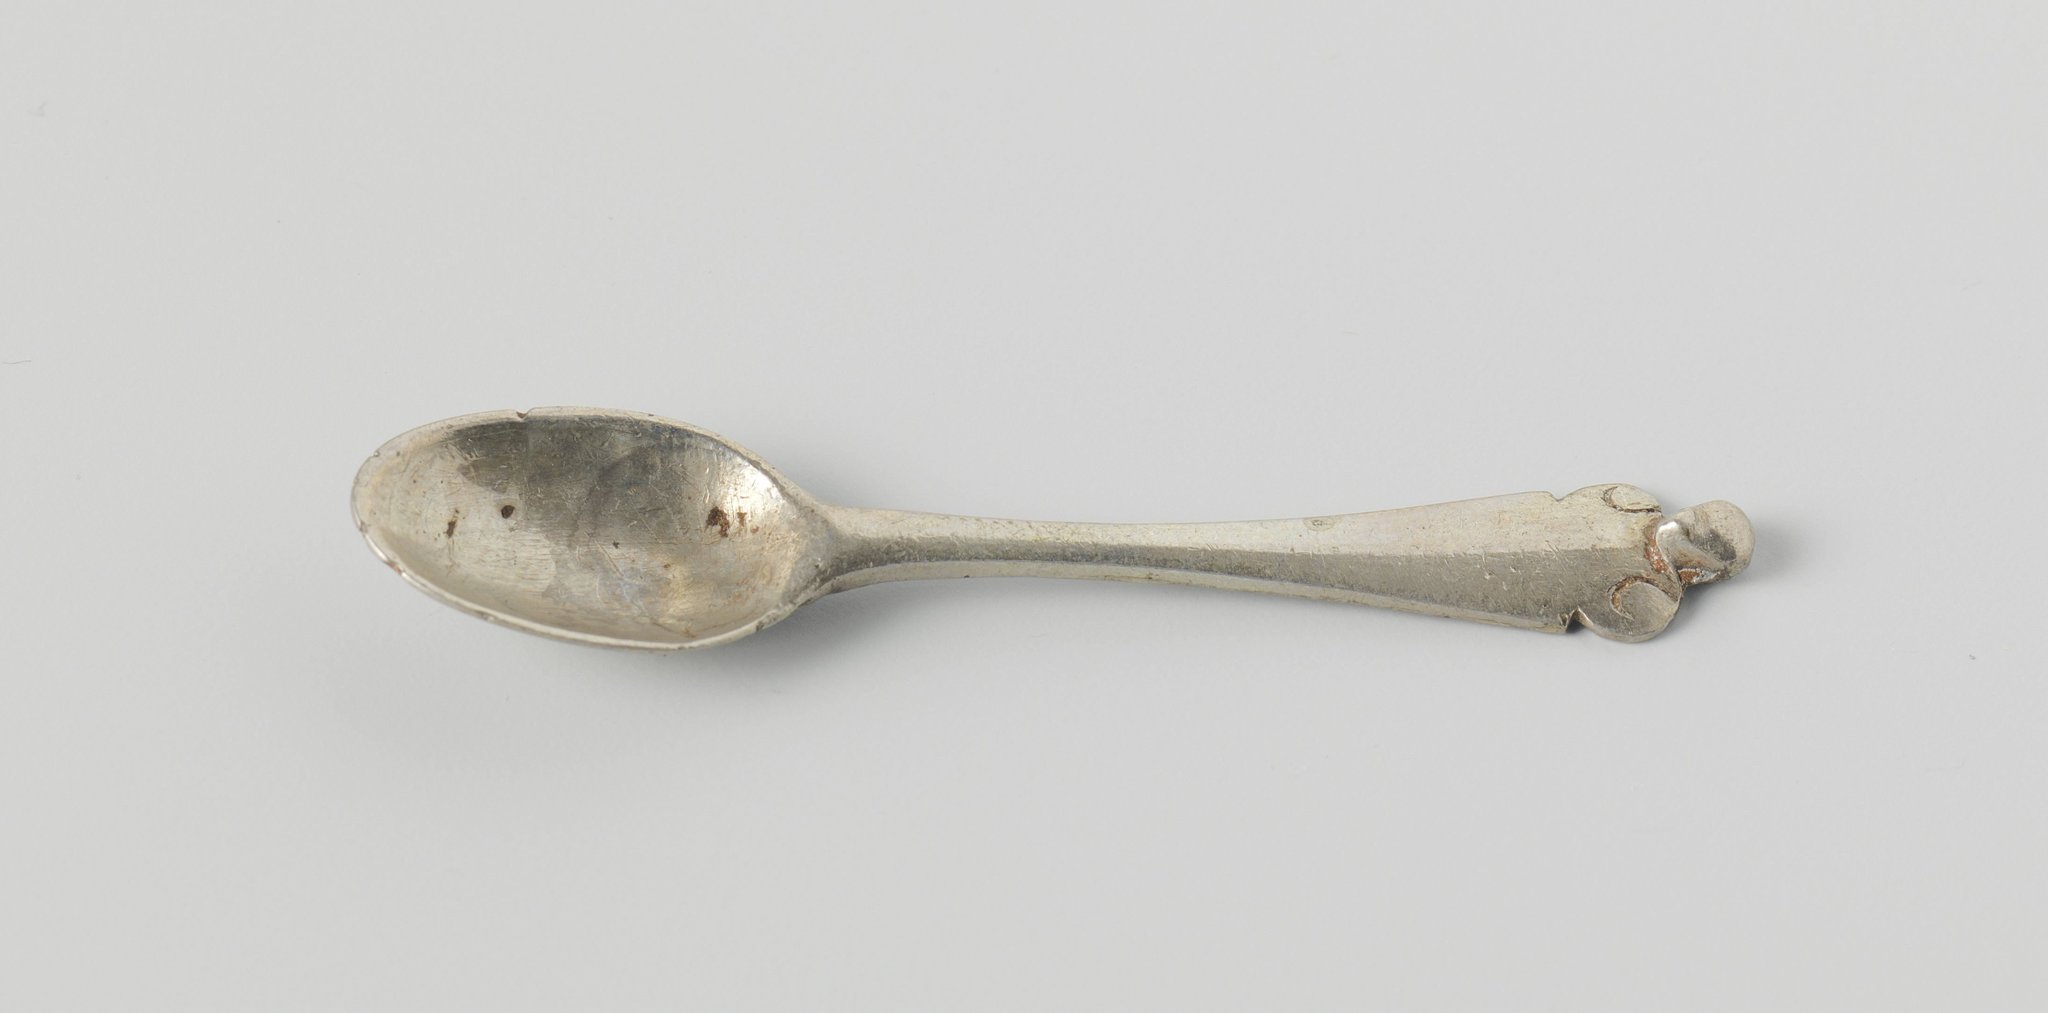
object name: miniature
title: Lepel met drielobbig uiteinde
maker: Anonymous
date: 1775-1800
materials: silver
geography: netherlands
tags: spoon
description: Ovale lepel met een breed uitlopende steel. De steel heeft een lobbig uiteinde. De lepel is niet gemerkt.